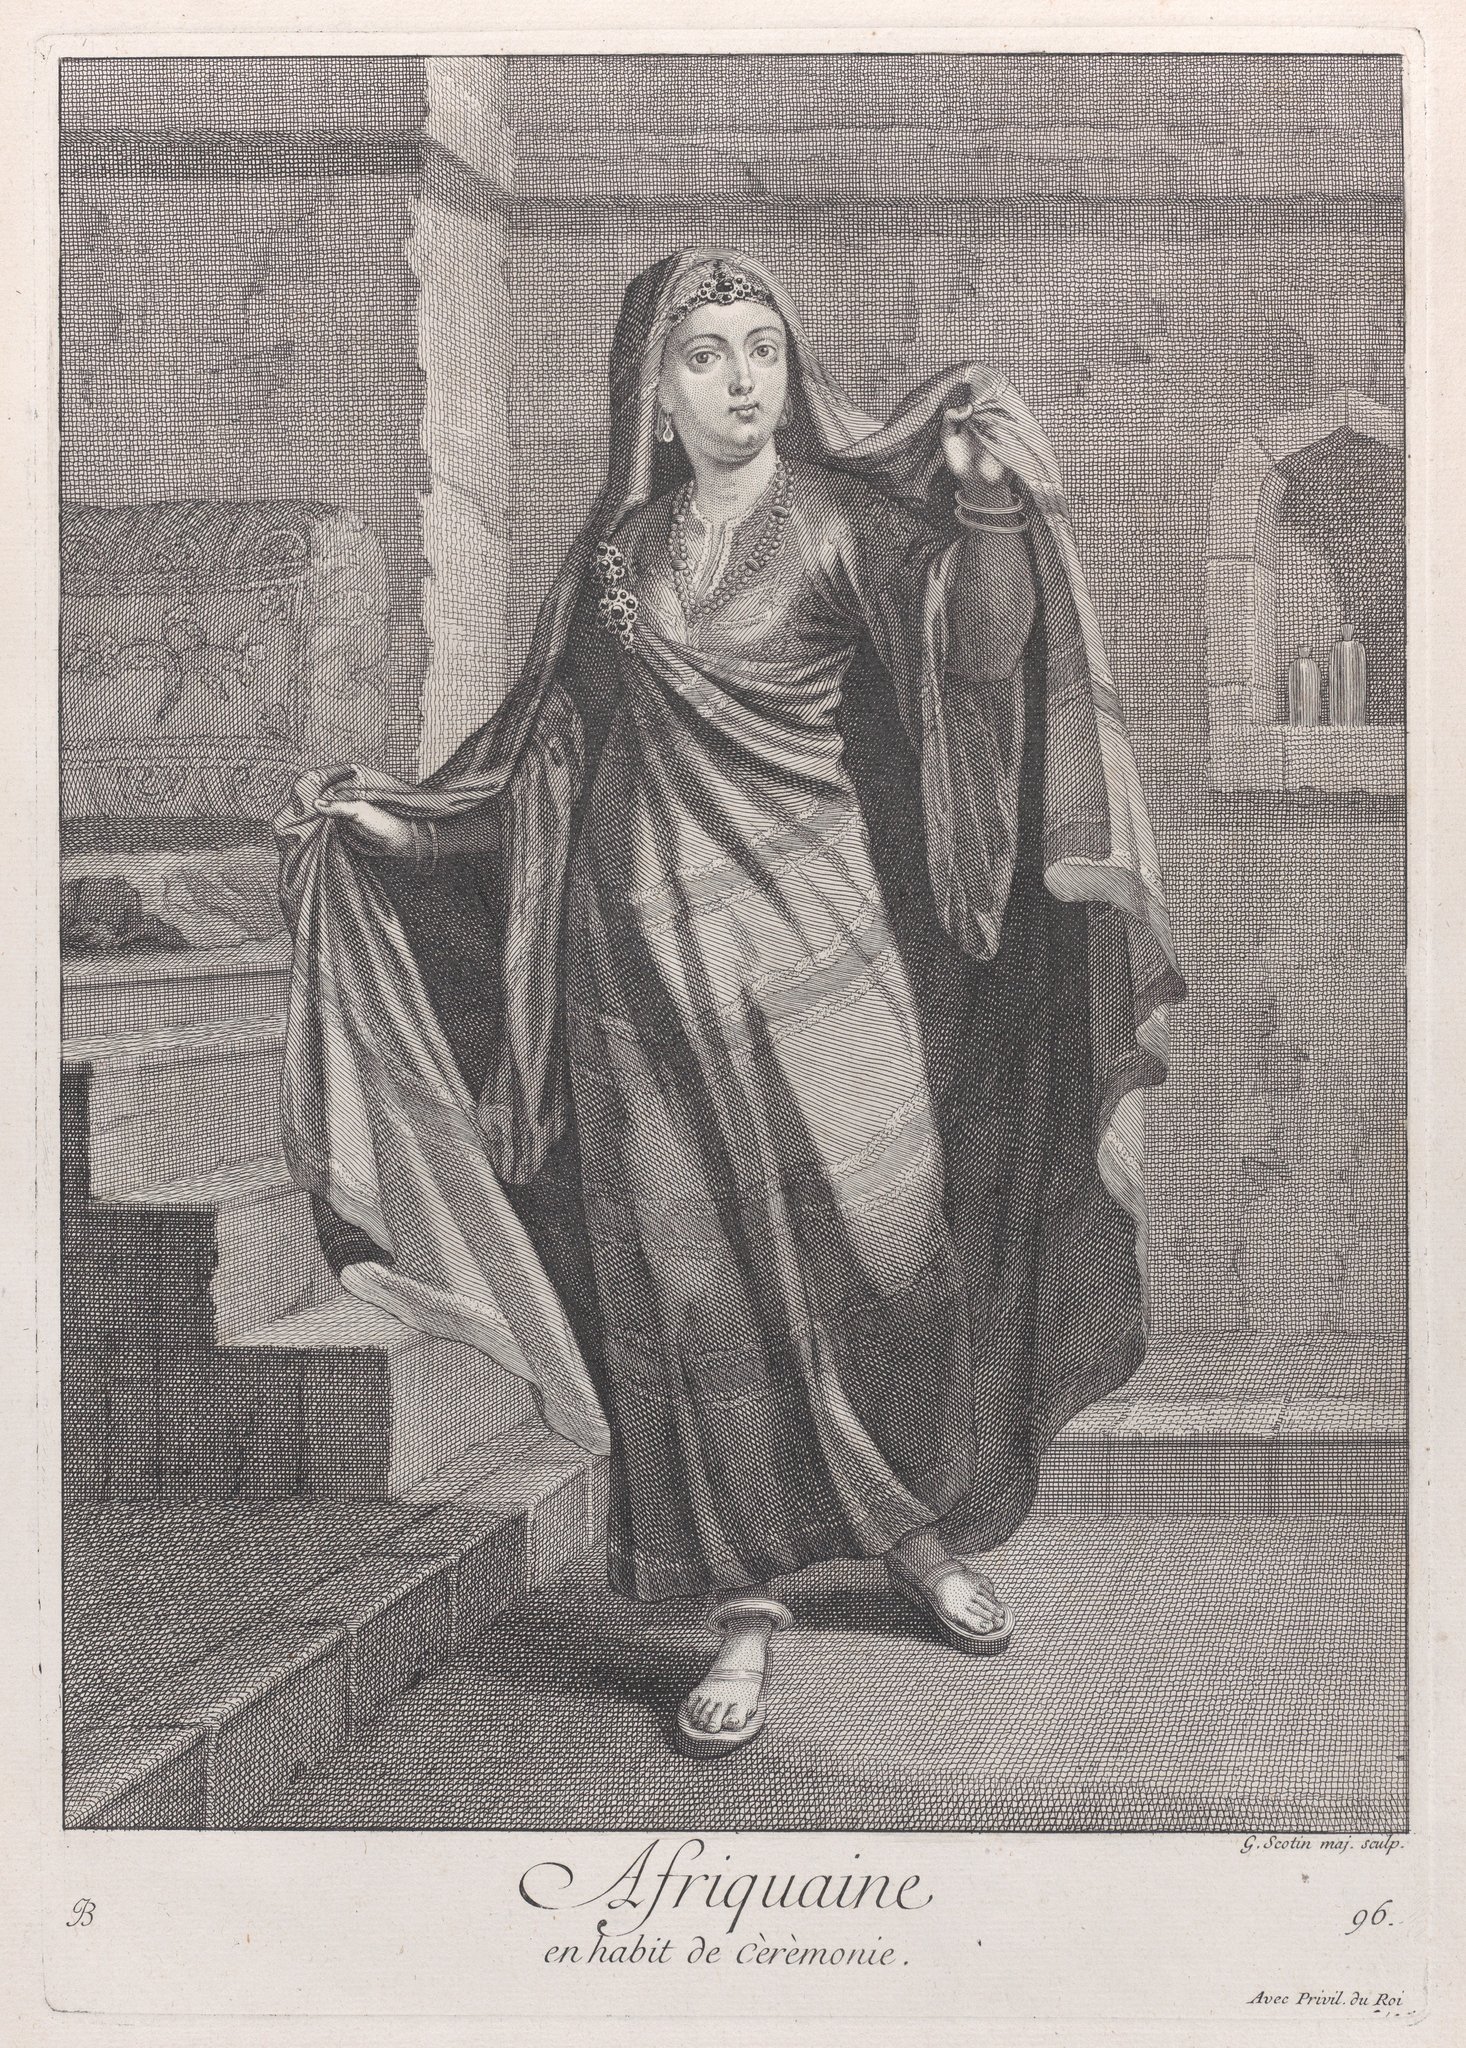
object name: print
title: Afriquaine, en habit de Cèrèmonie, plate 96 from "Recueil de cent estampes représentent differentes nations du Levant"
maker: jean baptiste vanmour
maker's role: artist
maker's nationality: french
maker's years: 1671-1737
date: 1714-1715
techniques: engraving, etching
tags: women